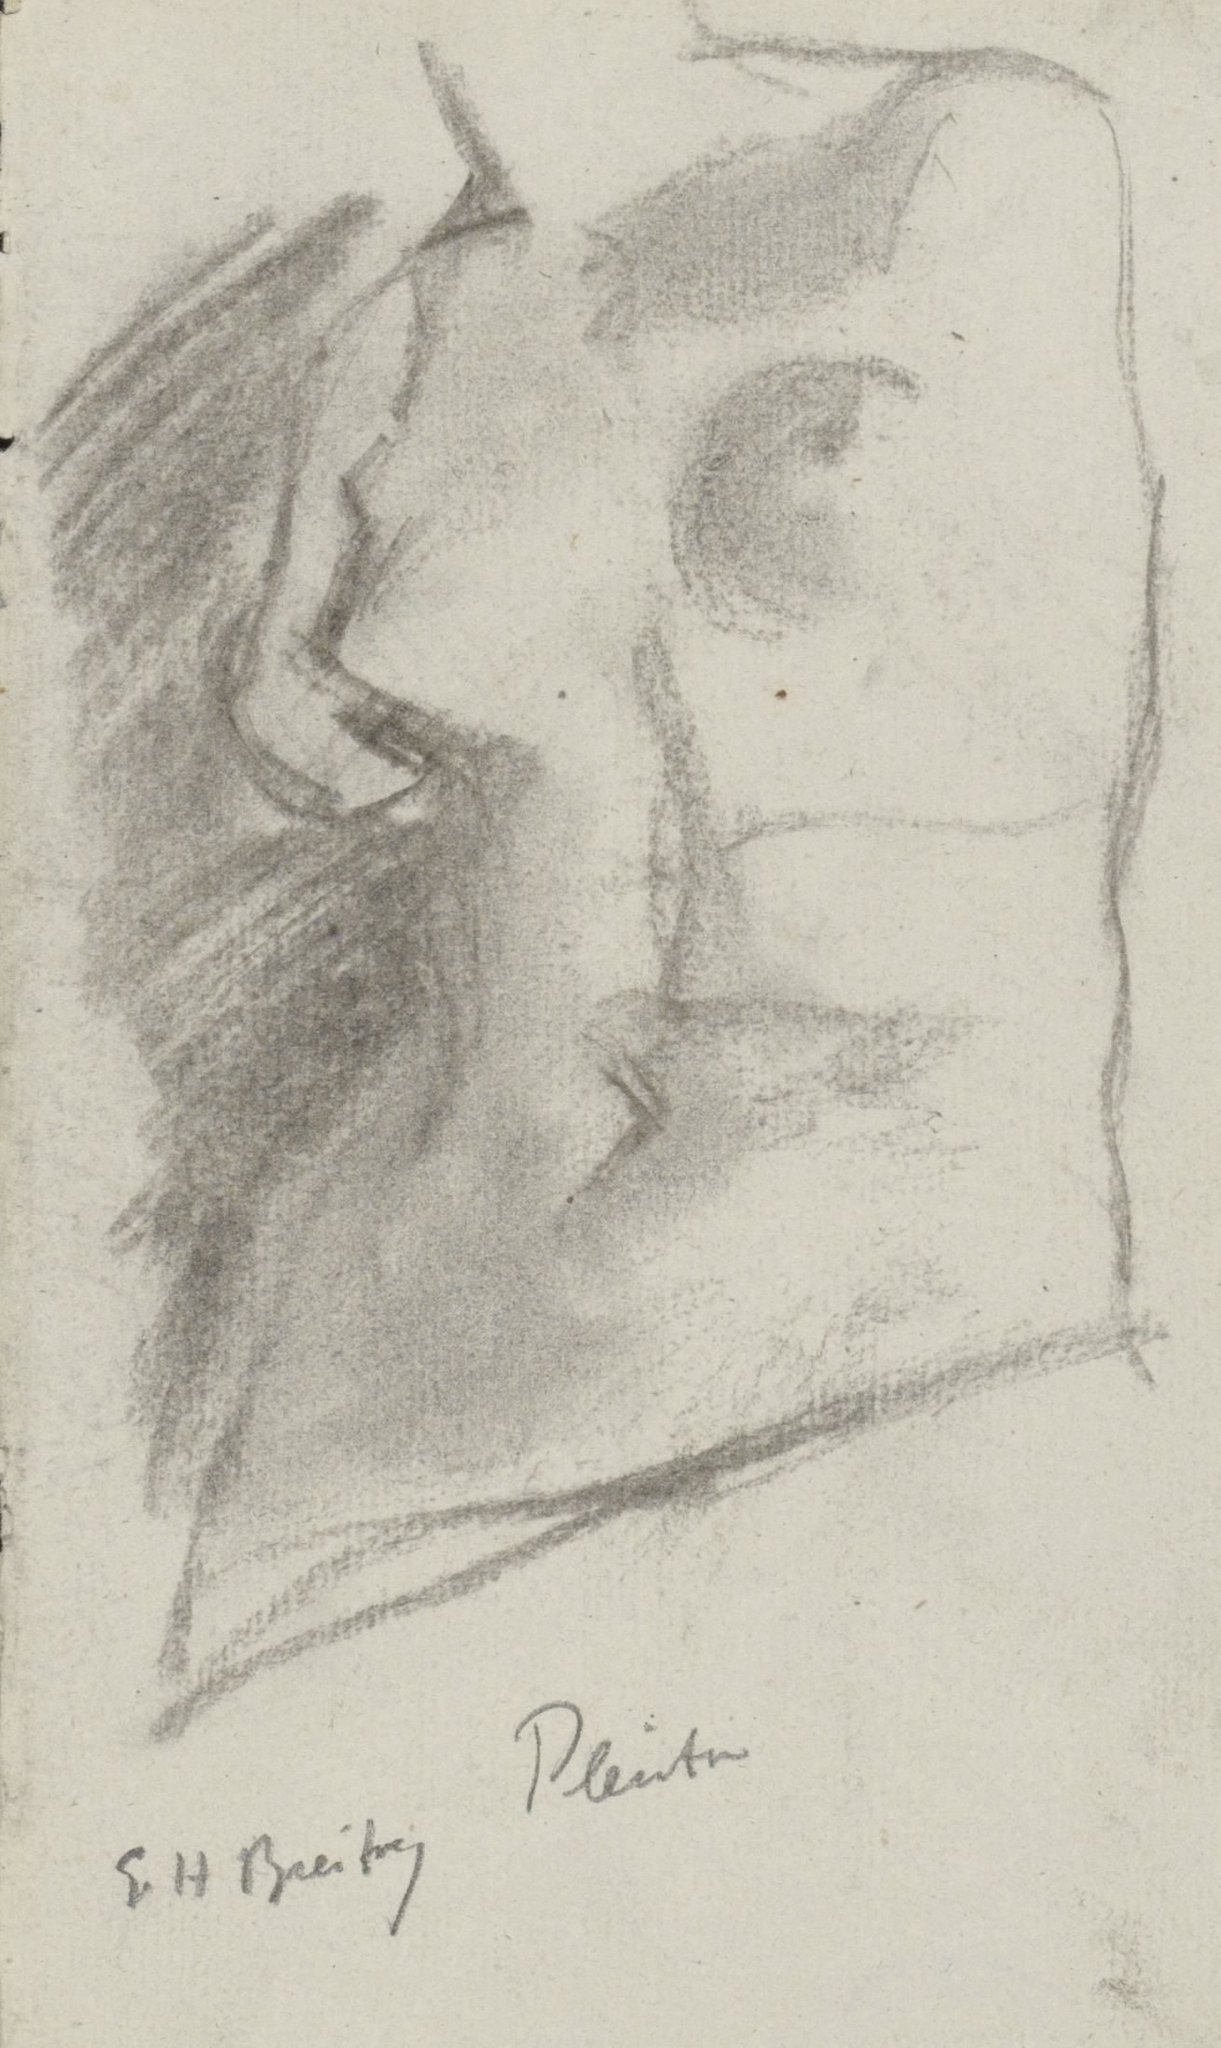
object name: drawing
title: Romp van de Venus van Milo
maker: george hendrik breitner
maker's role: draughtsman, painter, print maker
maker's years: 1857-1923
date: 1873-1886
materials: charcoal, paper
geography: netherlands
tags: parts of the human body (skeleton excepted) - aa - female human figure, piece of sculpture, reproduction of a piece of sculpture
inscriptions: signature: ‘G H Breitner’, annotation: ‘Plei[...]’